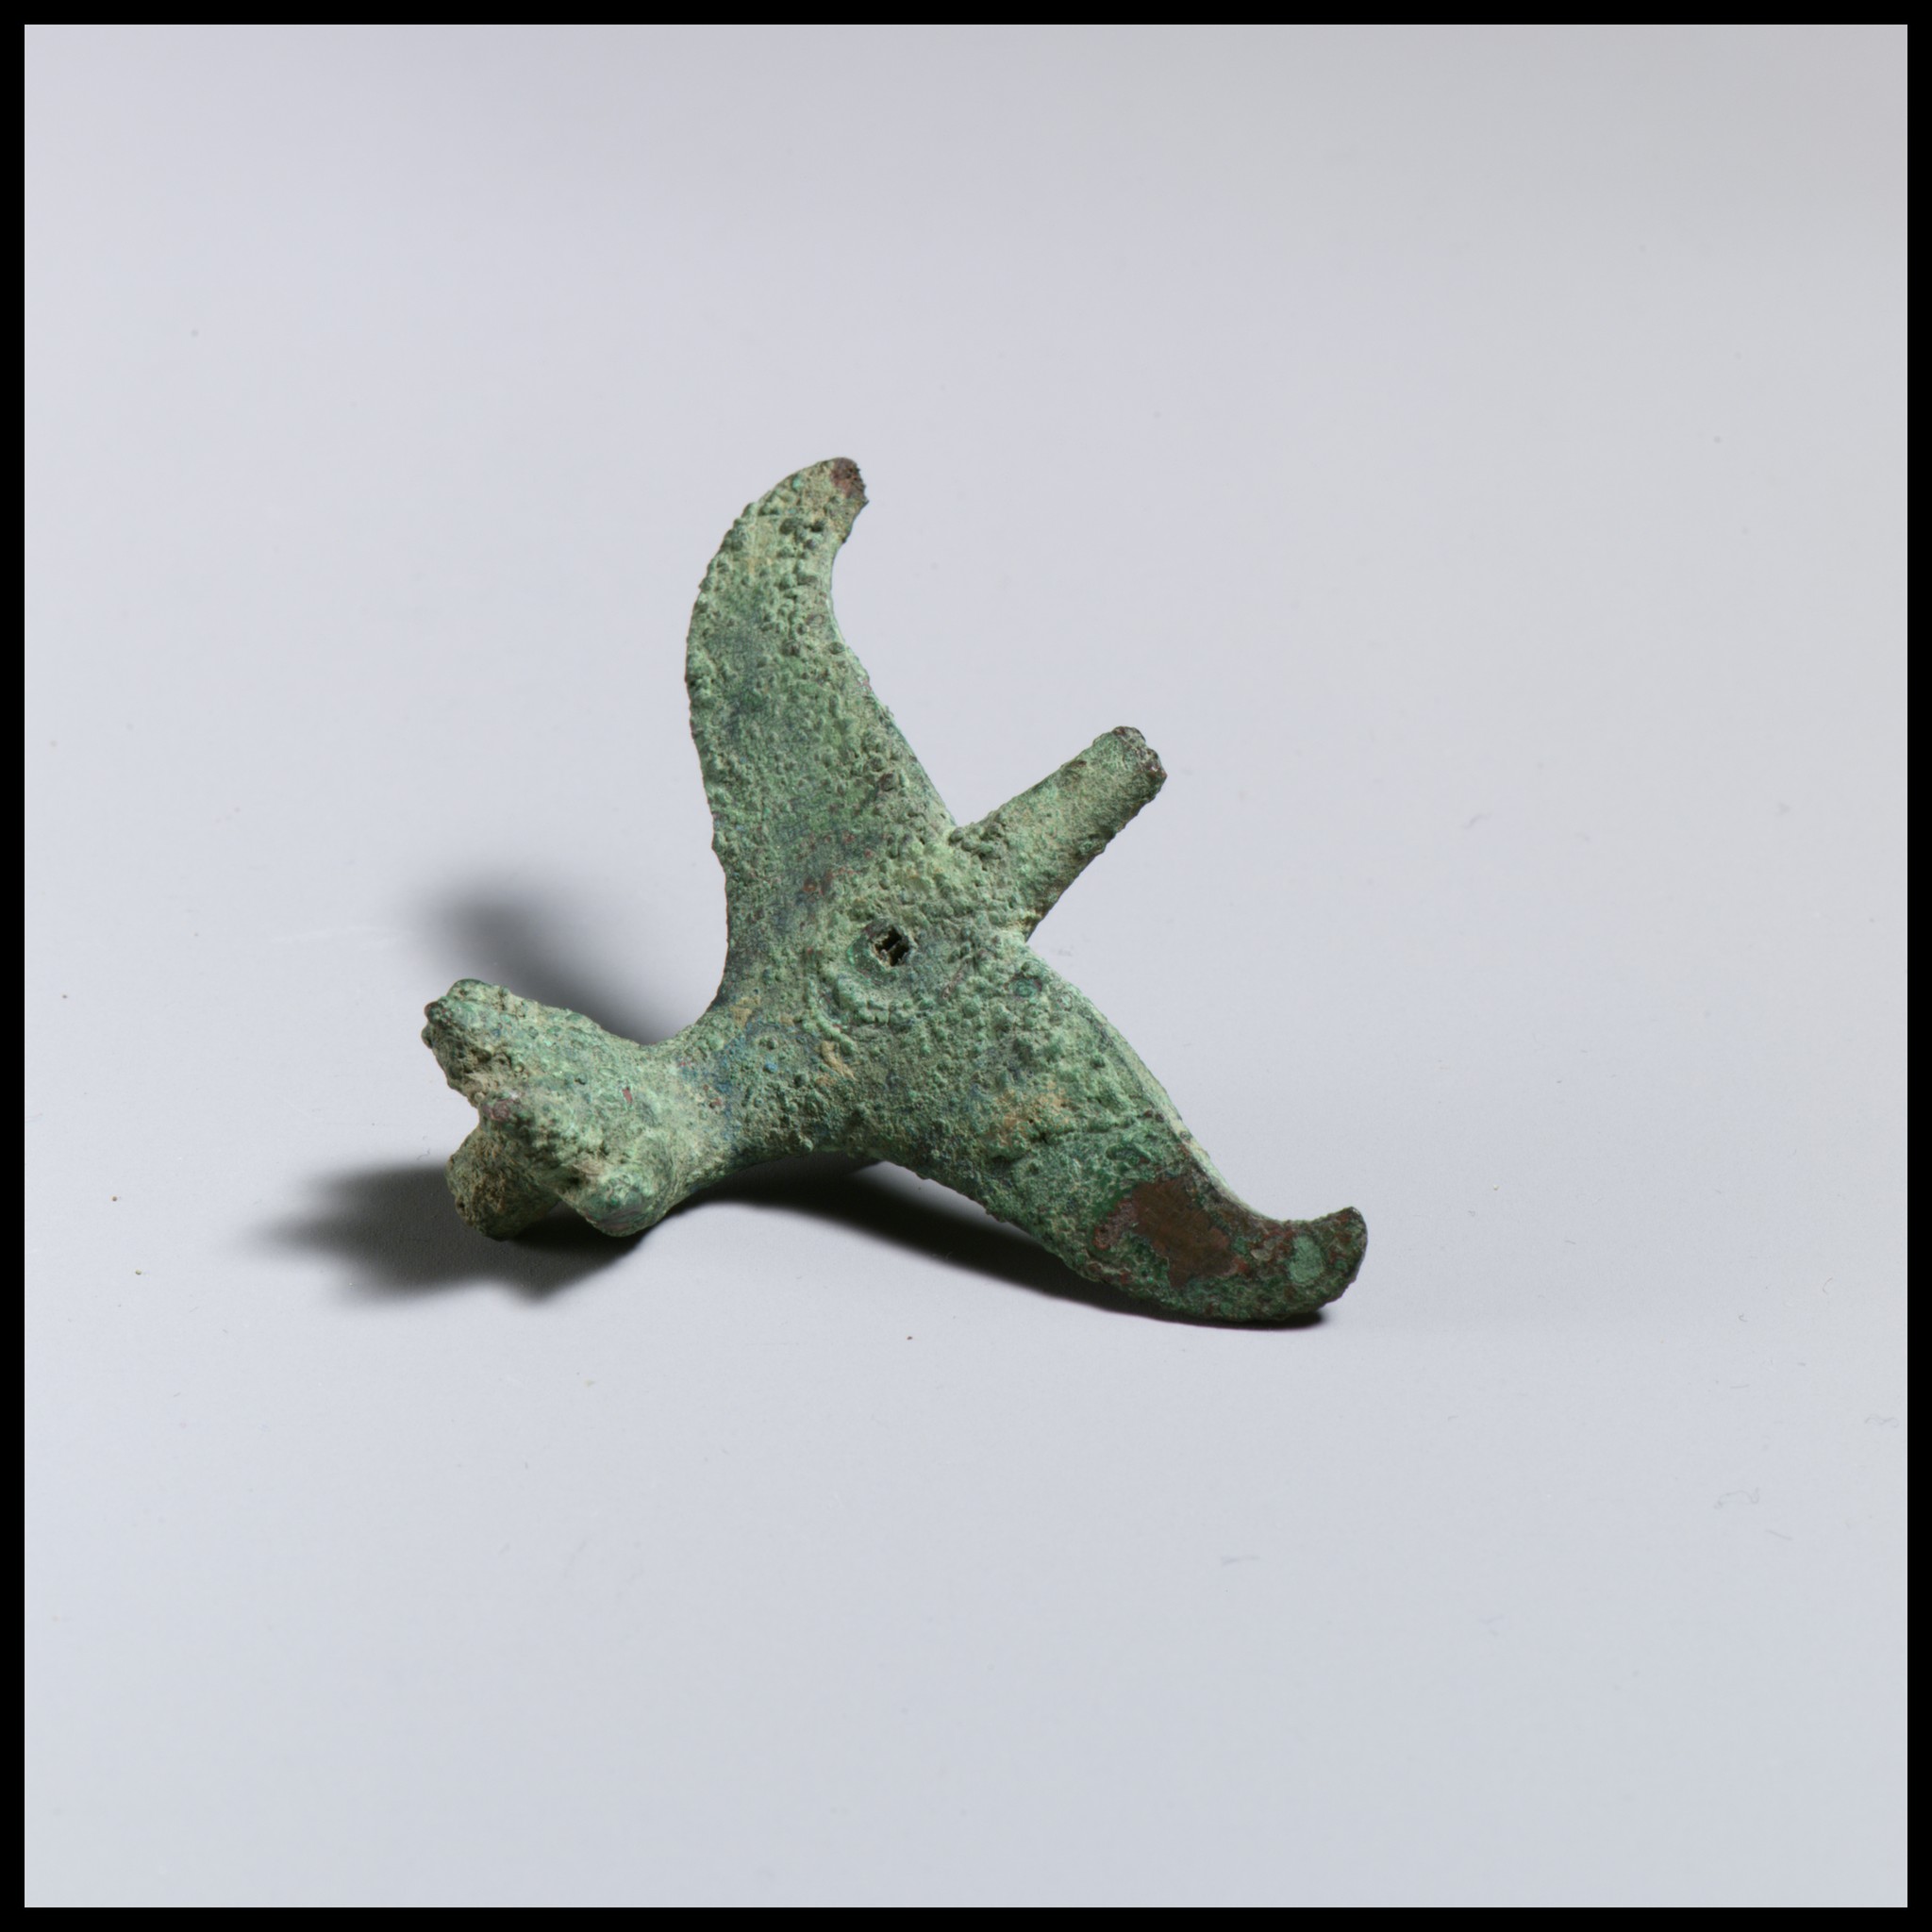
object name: cista, foot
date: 7000 BCE-330 CE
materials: bronze